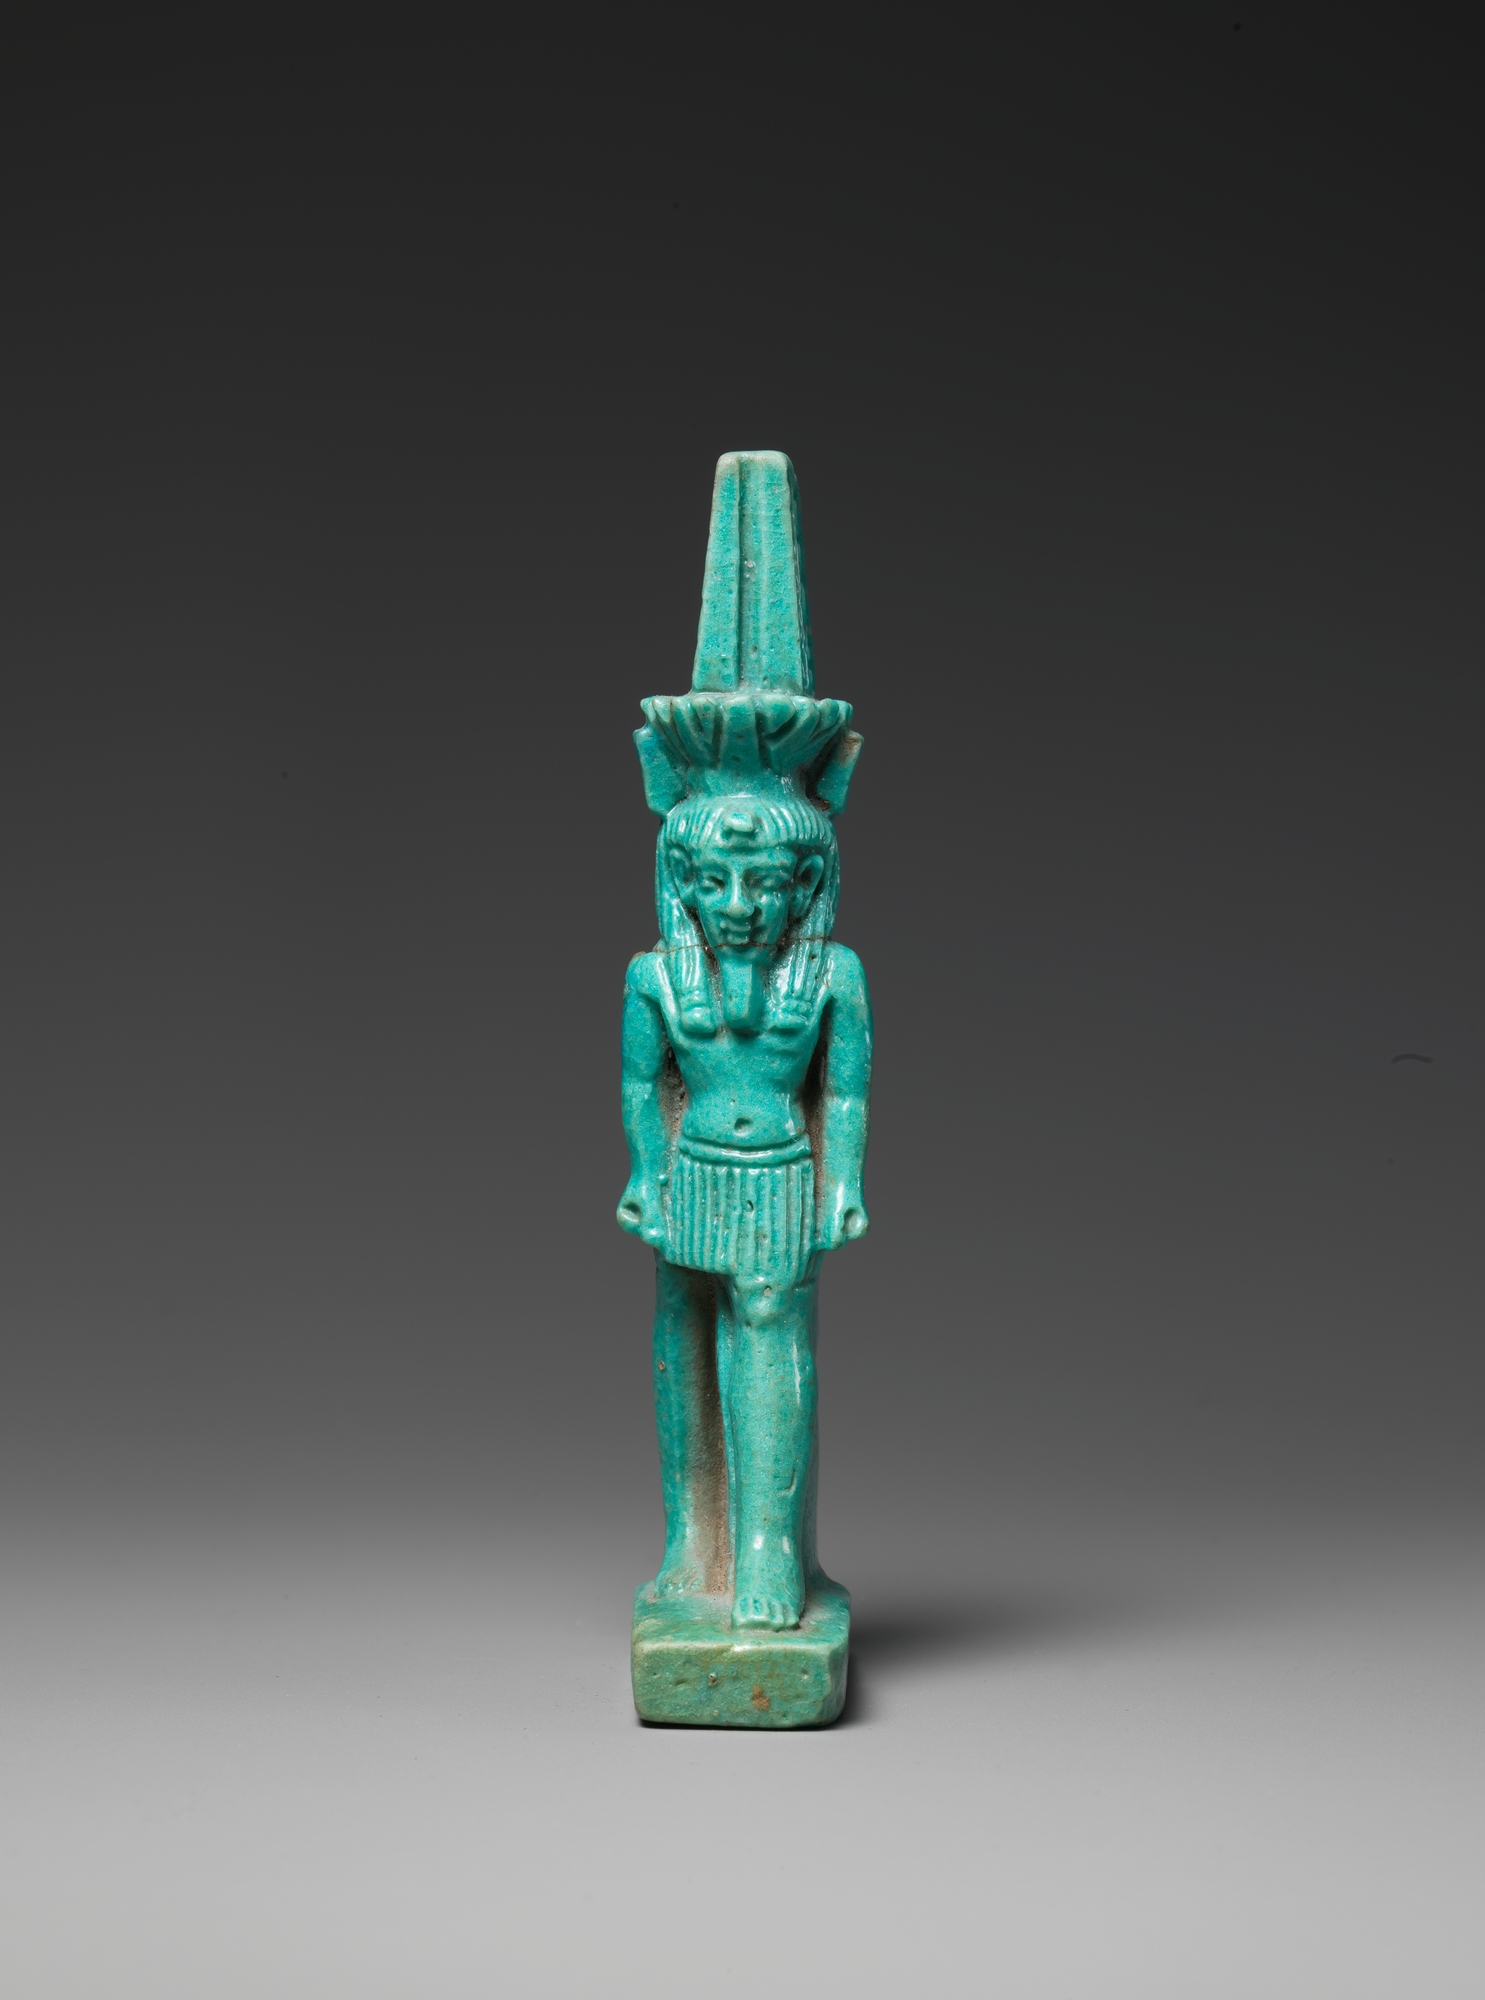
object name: amulet, nefertum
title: Nefertum Amulet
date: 1070-332 BCE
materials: faience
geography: egypt